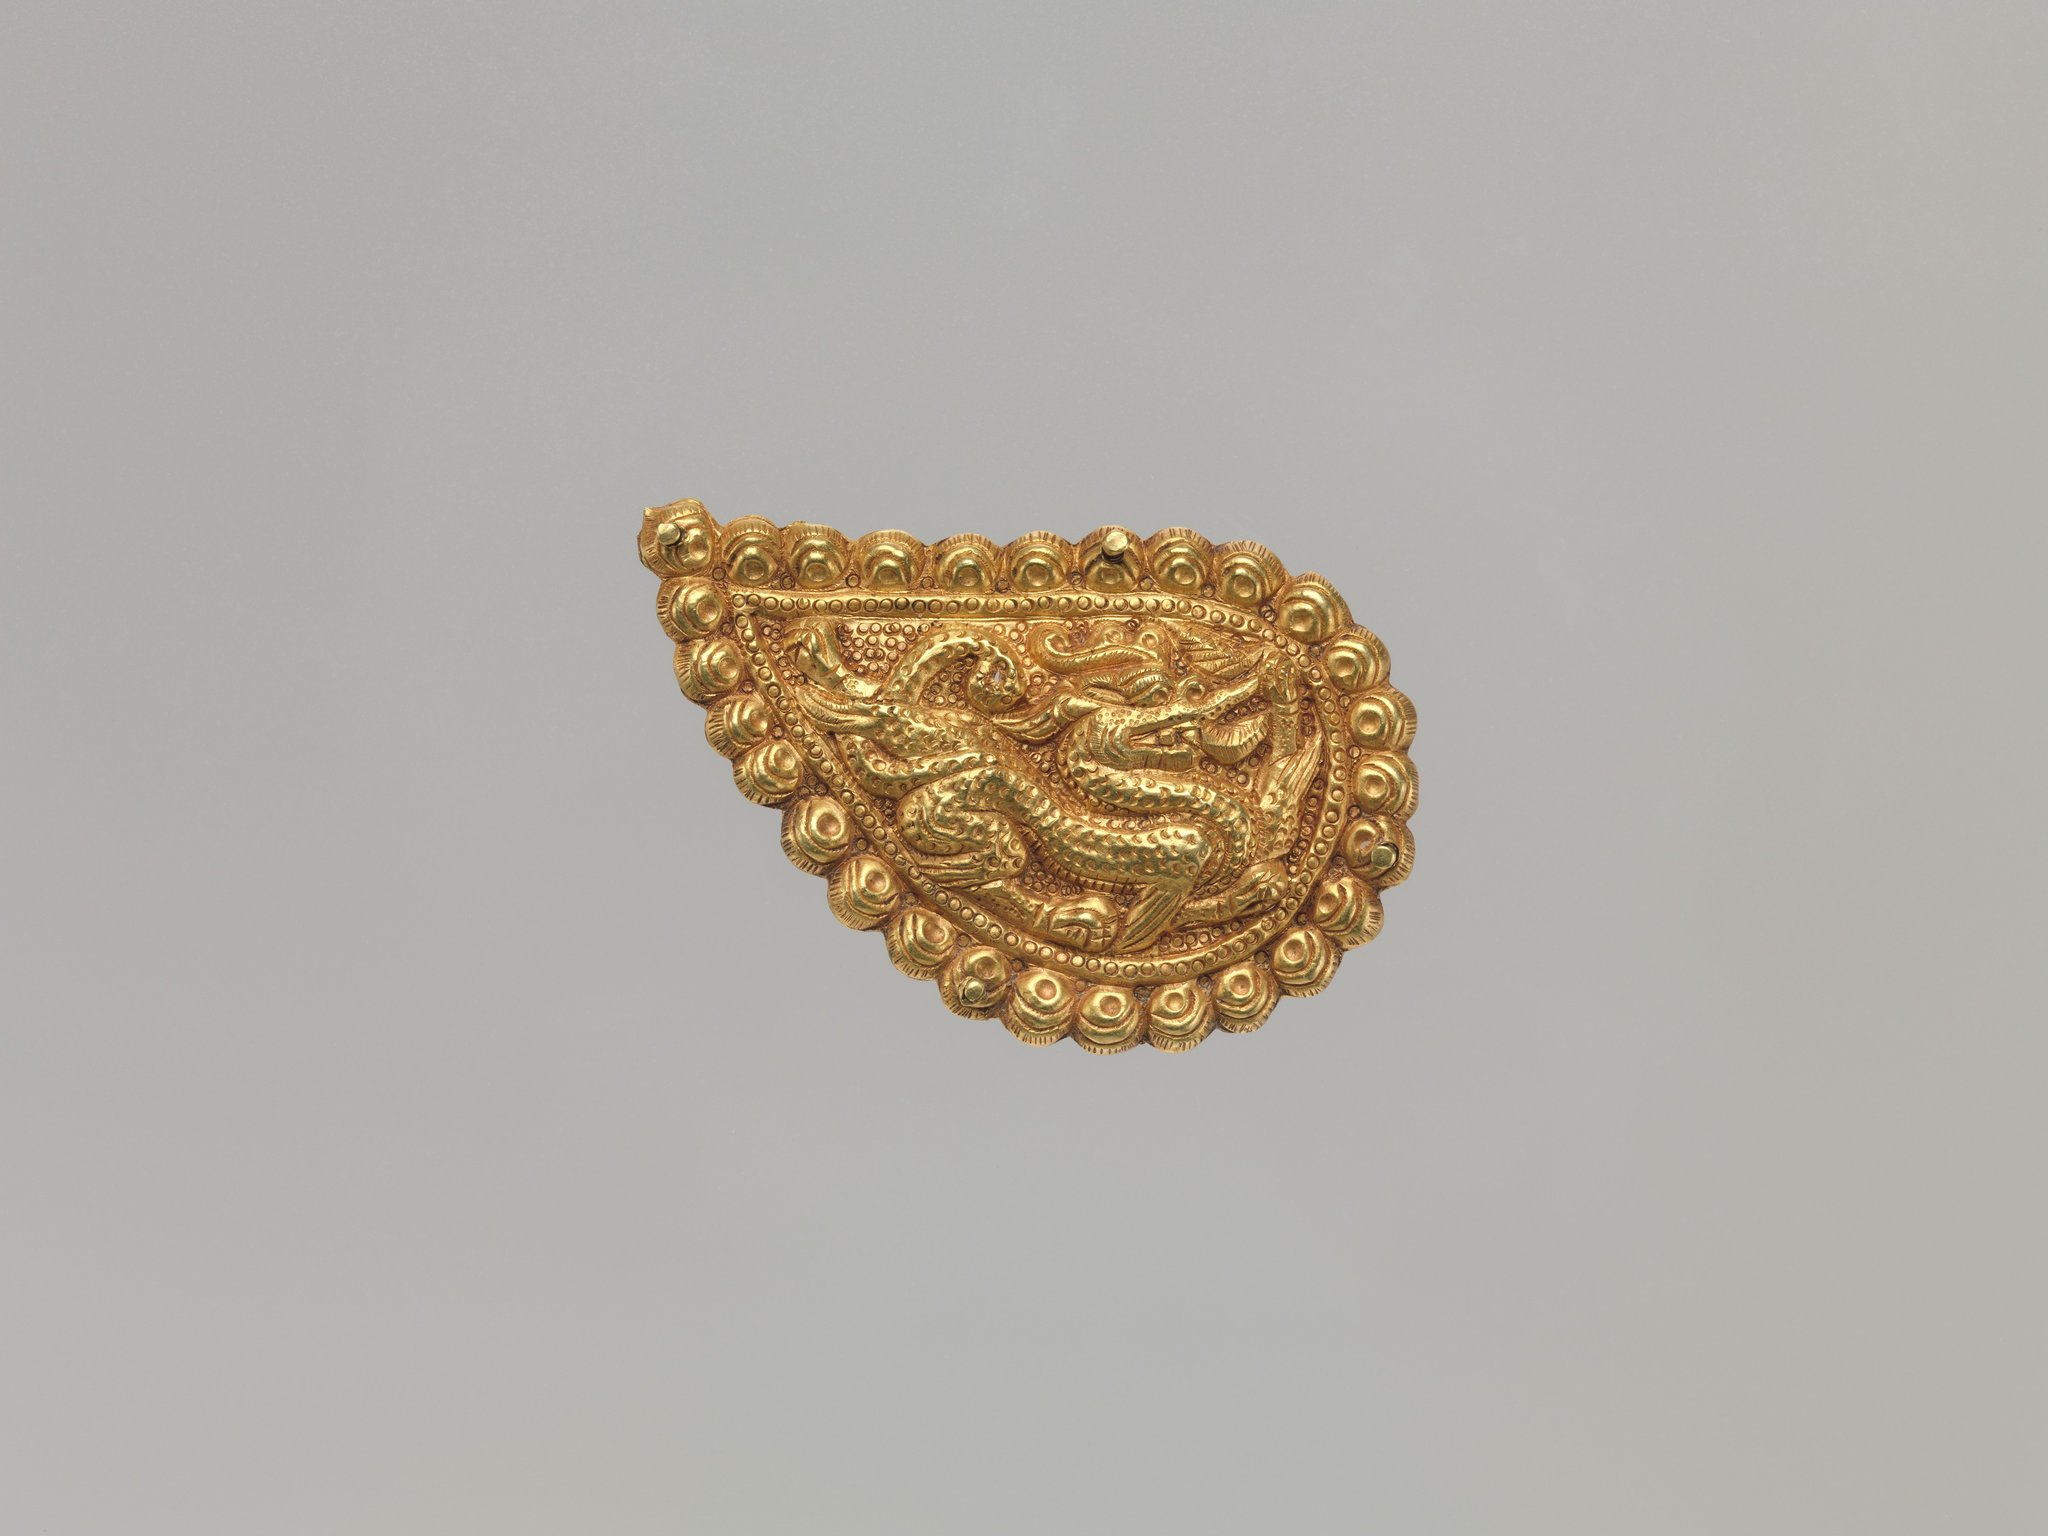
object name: plaque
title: Plaque with Dragon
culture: chinese or central asian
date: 601-900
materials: gold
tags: dragons